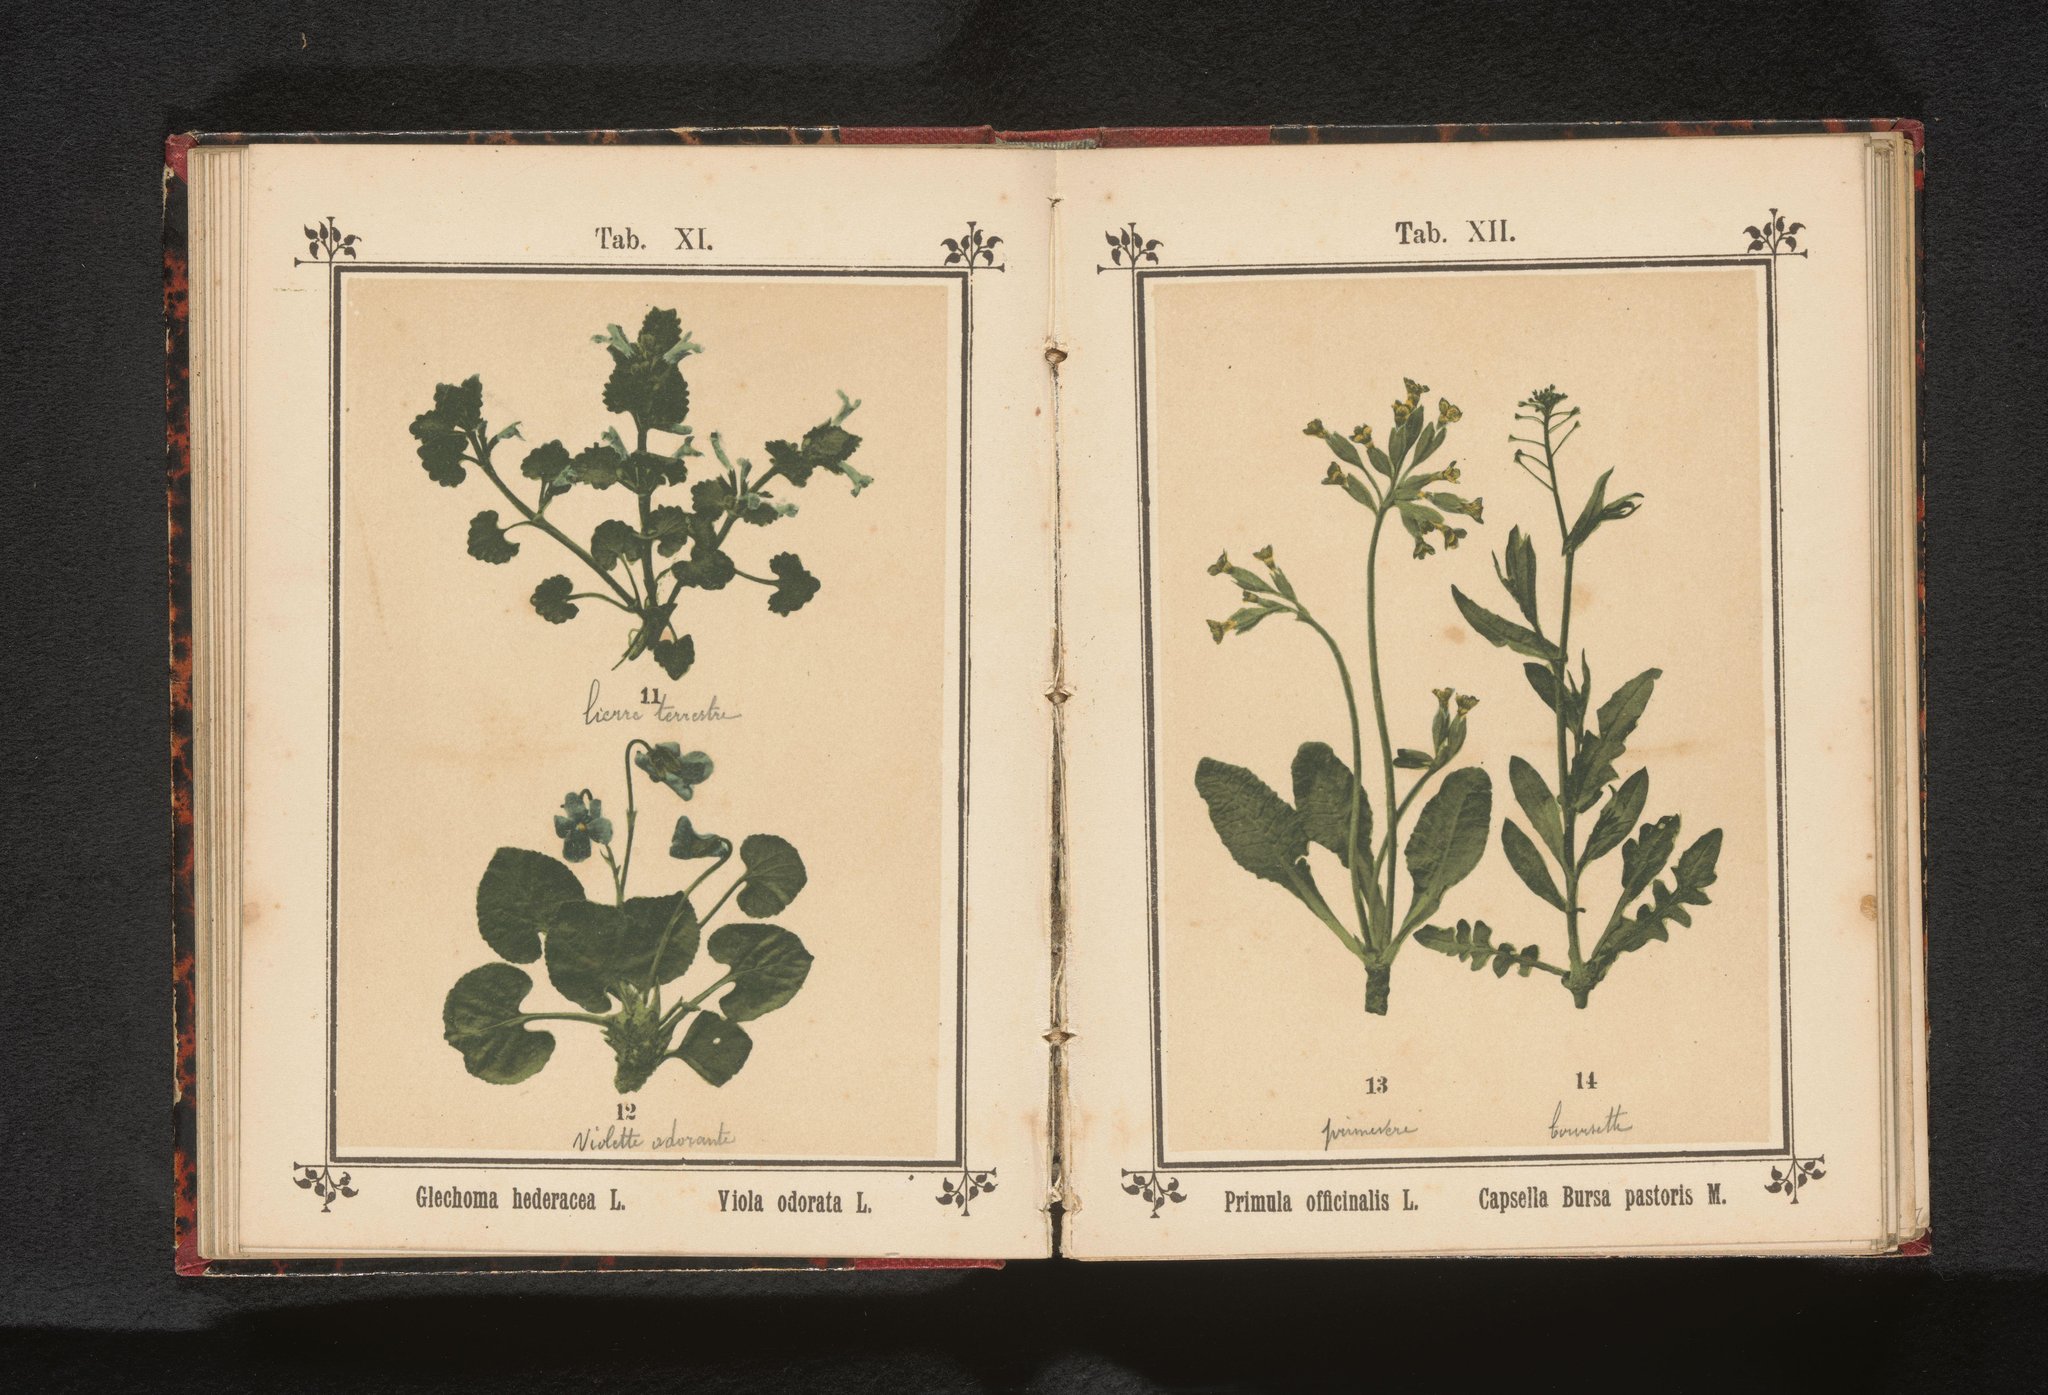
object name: photomechanical print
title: Primula officinalis L. Capsella Bursa pastoris M.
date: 1884-1894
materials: paper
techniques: photograph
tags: flowers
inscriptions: number: ‘Tab. XII.’, inscription: ‘primeveri boursette’